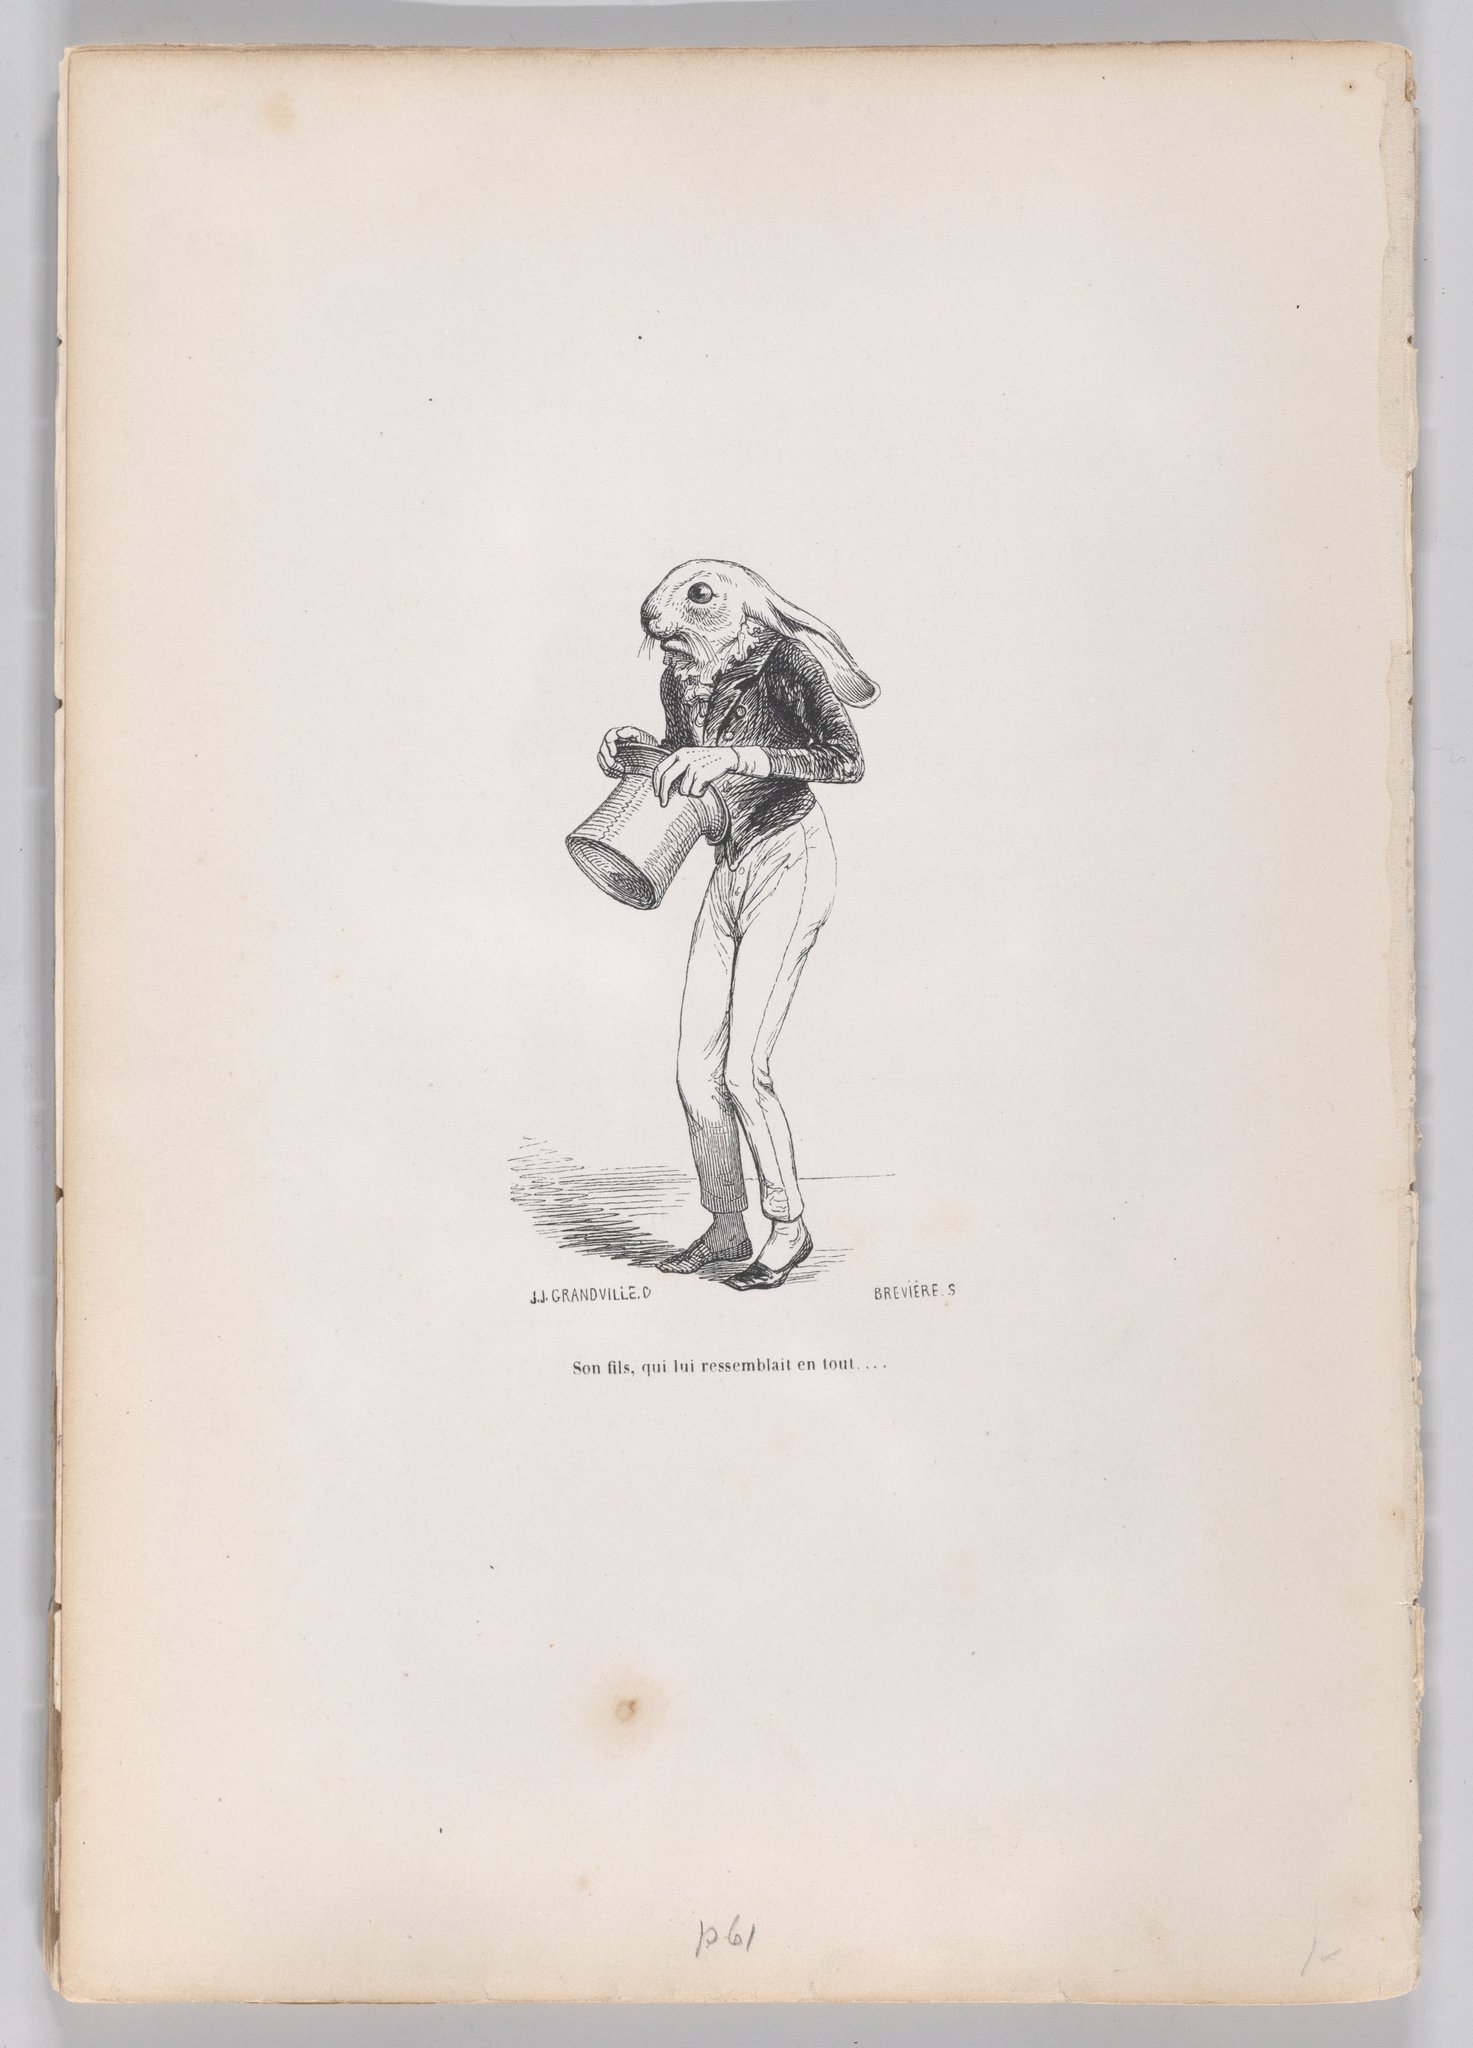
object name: print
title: His son, who looked like him in every way ..., from "Scenes from the Private and Public Life of Animals"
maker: j. j. grandville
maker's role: illustrator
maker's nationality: french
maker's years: 1803-1847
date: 1837-1847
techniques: engraving